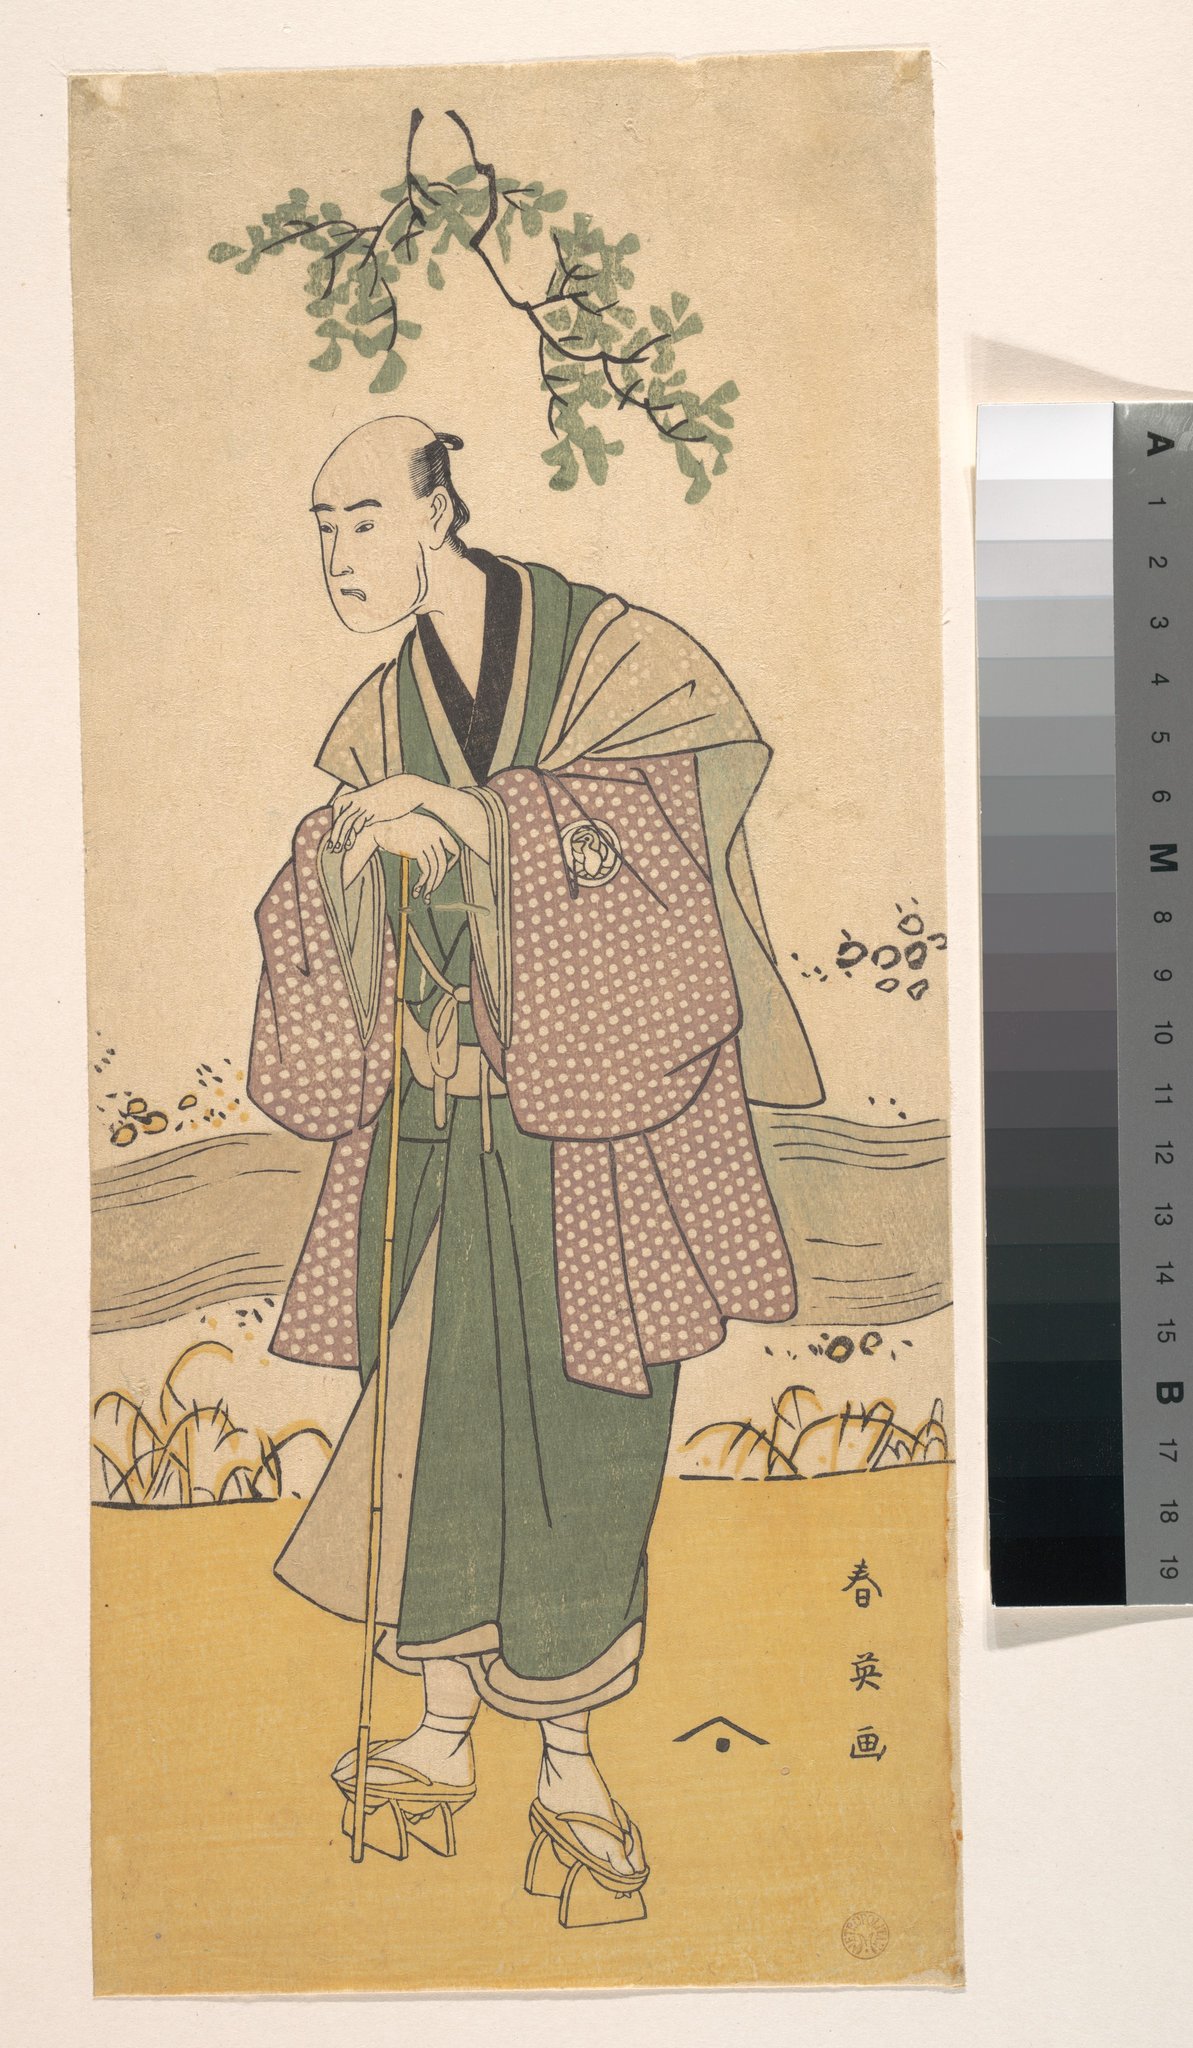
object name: print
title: The Third Bando Hikosaburo as a Man Standing on the Bank of a River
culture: japanese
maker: katsukawa shun'ei 勝川春英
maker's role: artist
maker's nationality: japanese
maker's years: 1762-1819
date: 1793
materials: ink, paper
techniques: woodblock print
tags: leaves,actors